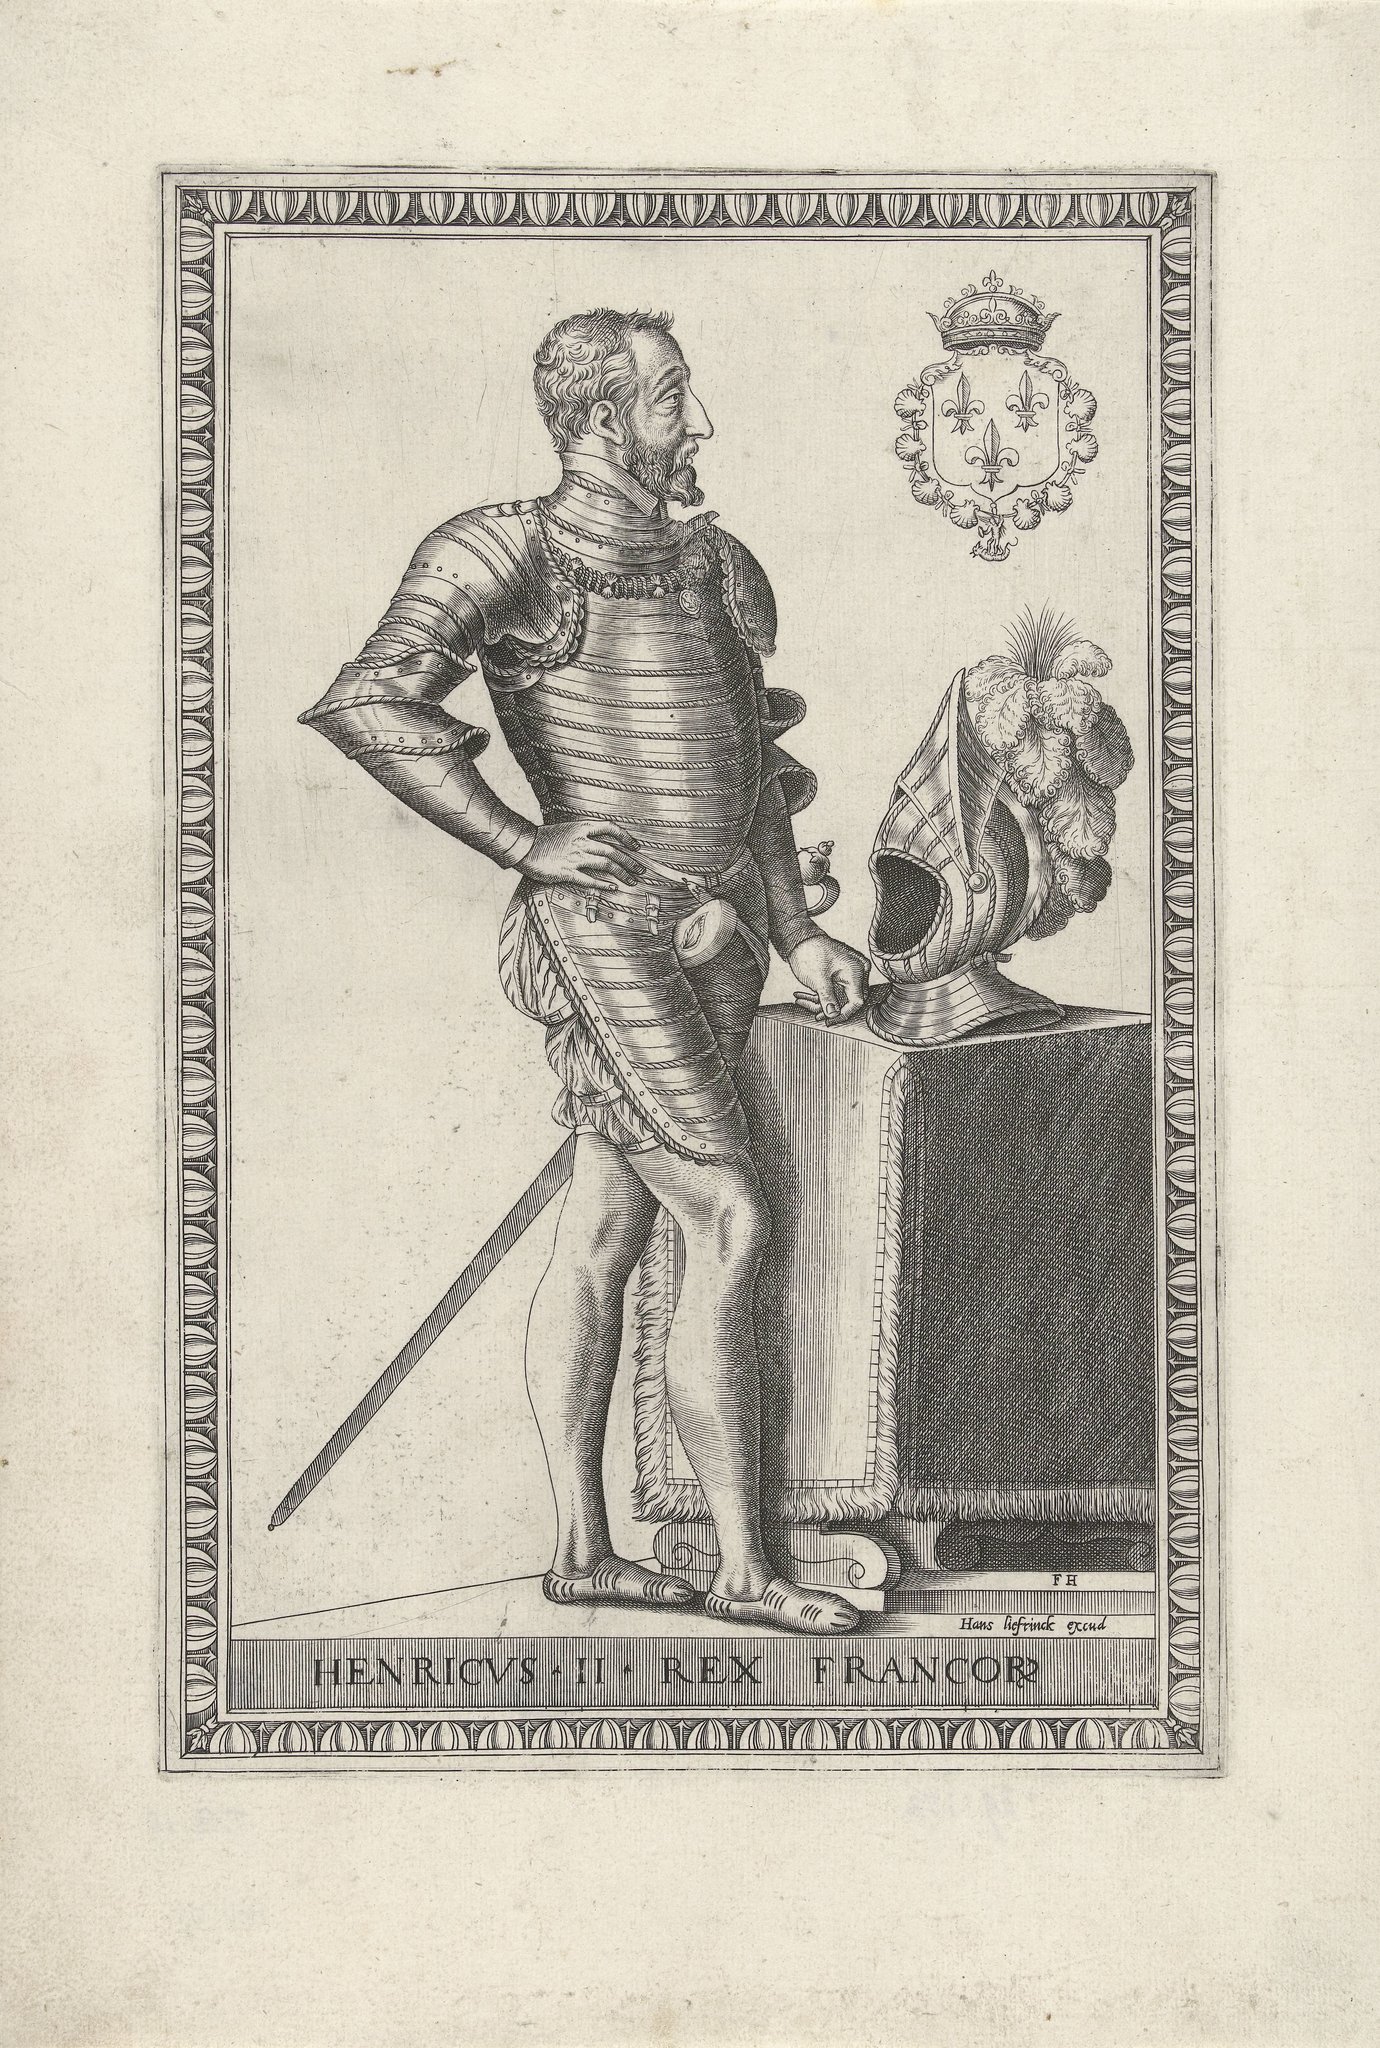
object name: print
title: Portretten van koningen en koninginnen ten voeten uit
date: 1546-1562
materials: paper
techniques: engraving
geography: antwerp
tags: paris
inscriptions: collector's mark: Lugt 2228, collector's mark: Lugt 2760, collector's mark: Lugt 151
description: Portret van Hendrik II, koning van Frankrijk, ten voeten uit naar rechts gekleed in harnas bij een tafel, daarop een helm. Rechtsboven zijn wapenschild.